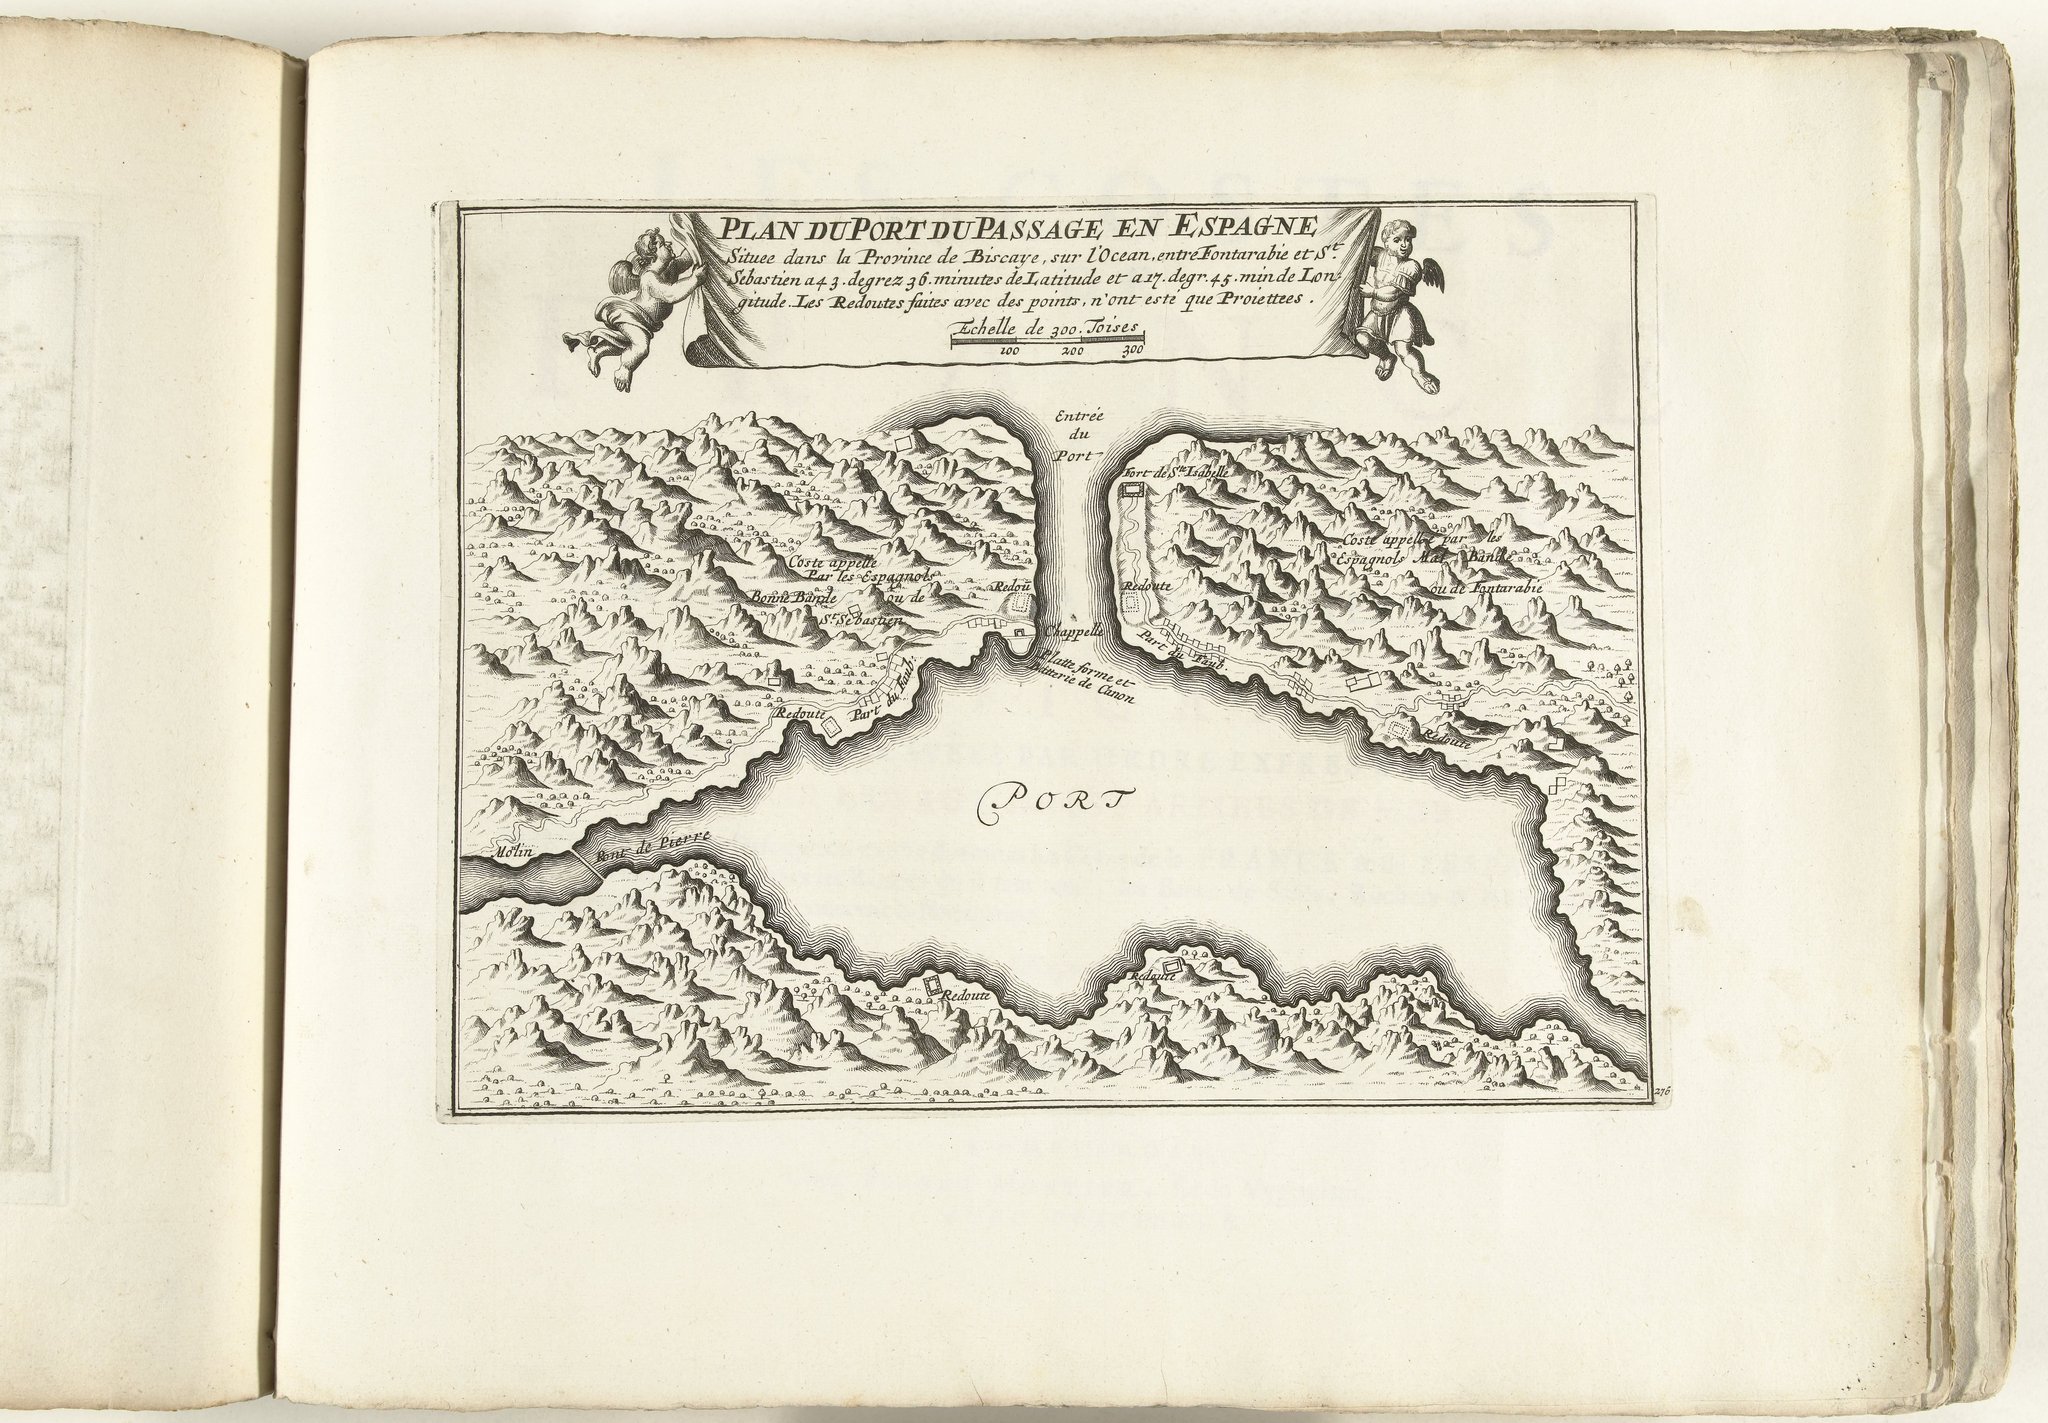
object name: print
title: Kaart van de natuurlijke haven van Puerto de Pasajes, ca. 1702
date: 1702-1703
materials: paper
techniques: etching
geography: amsterdam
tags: maps of separate countries or regions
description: Kaart van de natuurlijke haven van Puerto de Pasajes aan de Spaanse Noordkust bij San Sebastian. Plaat nr. 276 in het prentwerk bestaande in totaal uit 276 genummerde platen van vermaarde sterke steden en vestingen in het kader van de Spaanse Successieoorlog. Voor het merendeel zijn deze platen gekopieerd naar de anonieme Franse platen: in Les forces de l'Europe en in: Le theatre de la guerre, dans les Pays-Bas, beide oorspronkelijk uitgegeven door Nicolas de Fer te Parijs (1693-1697) in het kader van de Negenjarige Oorlog. Titel en opschriften in de plaat in het Frans.